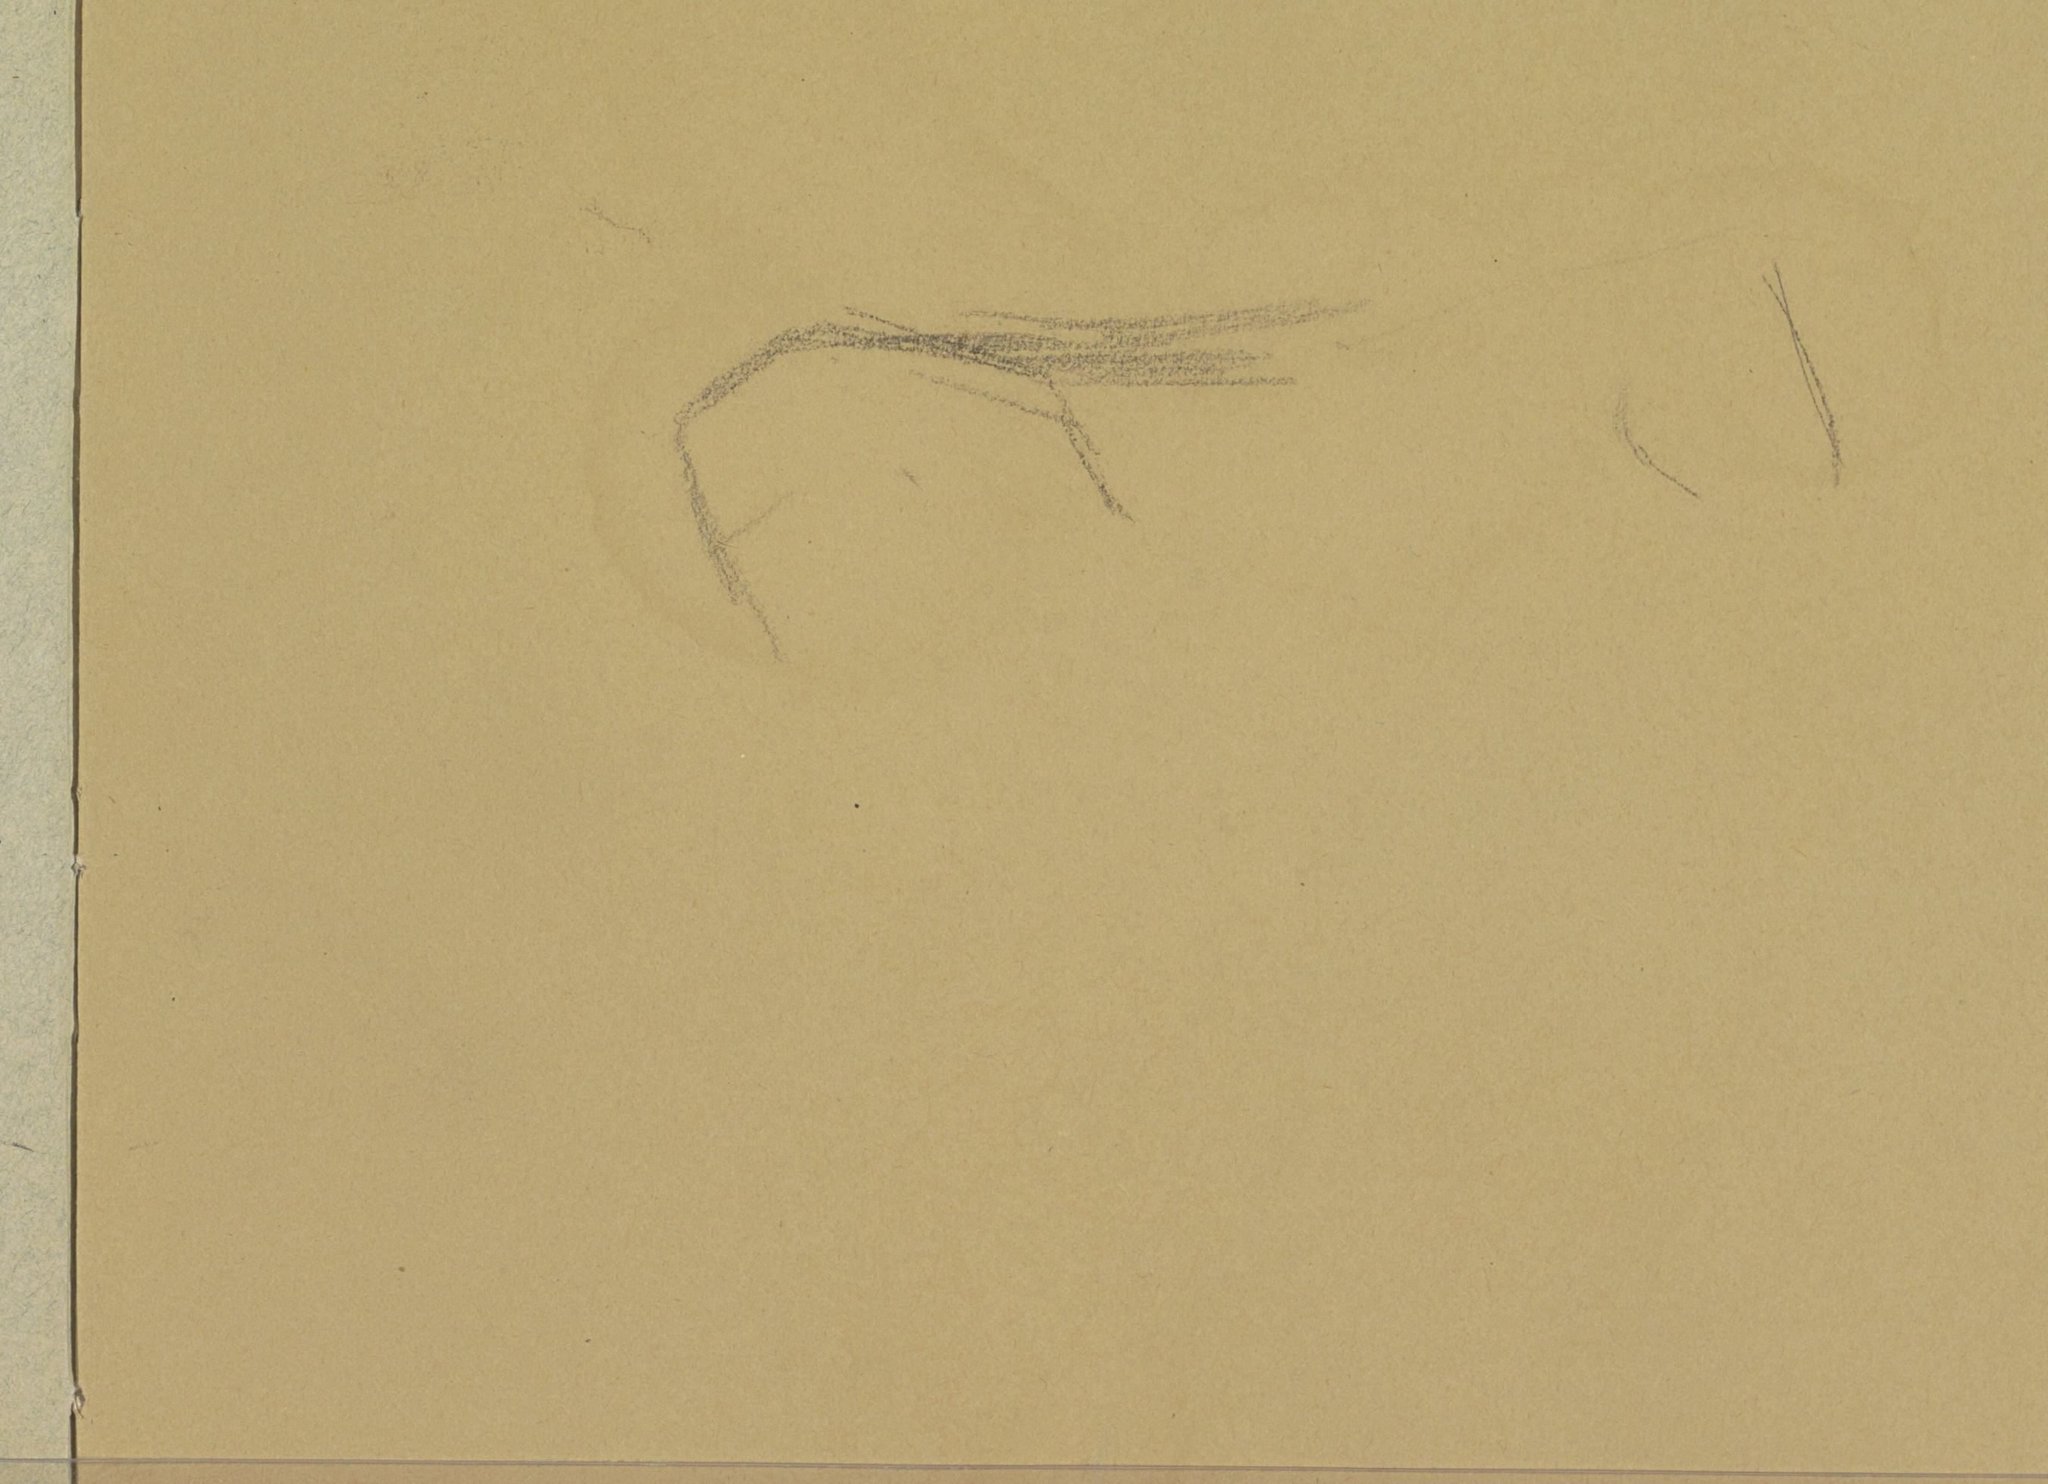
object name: sketchbook leaf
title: Studie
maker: isaac israels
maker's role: draughtsman, painter, print maker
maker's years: 1865-1934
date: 1890-1920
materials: chalk, paper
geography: the hague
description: Blad 18 recto uit schetsboek X met 43 bladen.